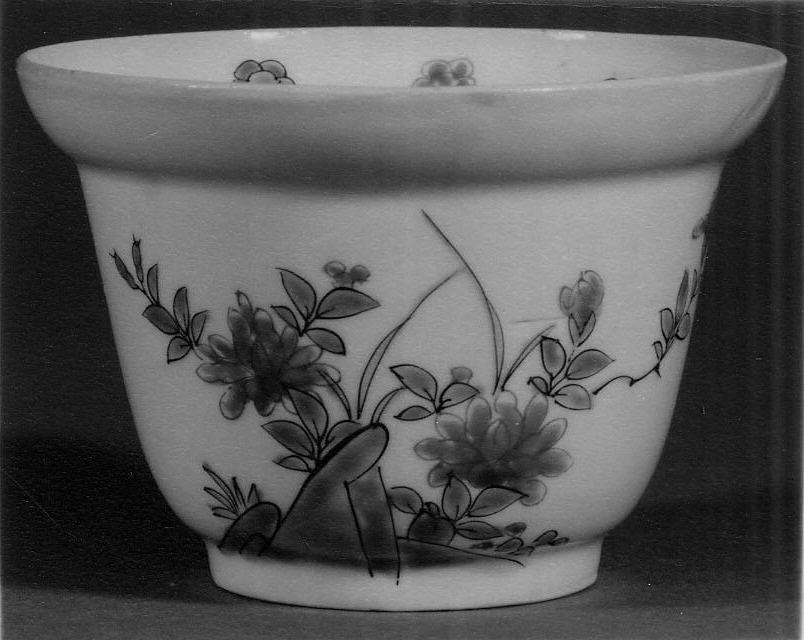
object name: cup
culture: japanese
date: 1601-1700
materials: enamel, porcelain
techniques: overglaze, painting, polychrome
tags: flowers